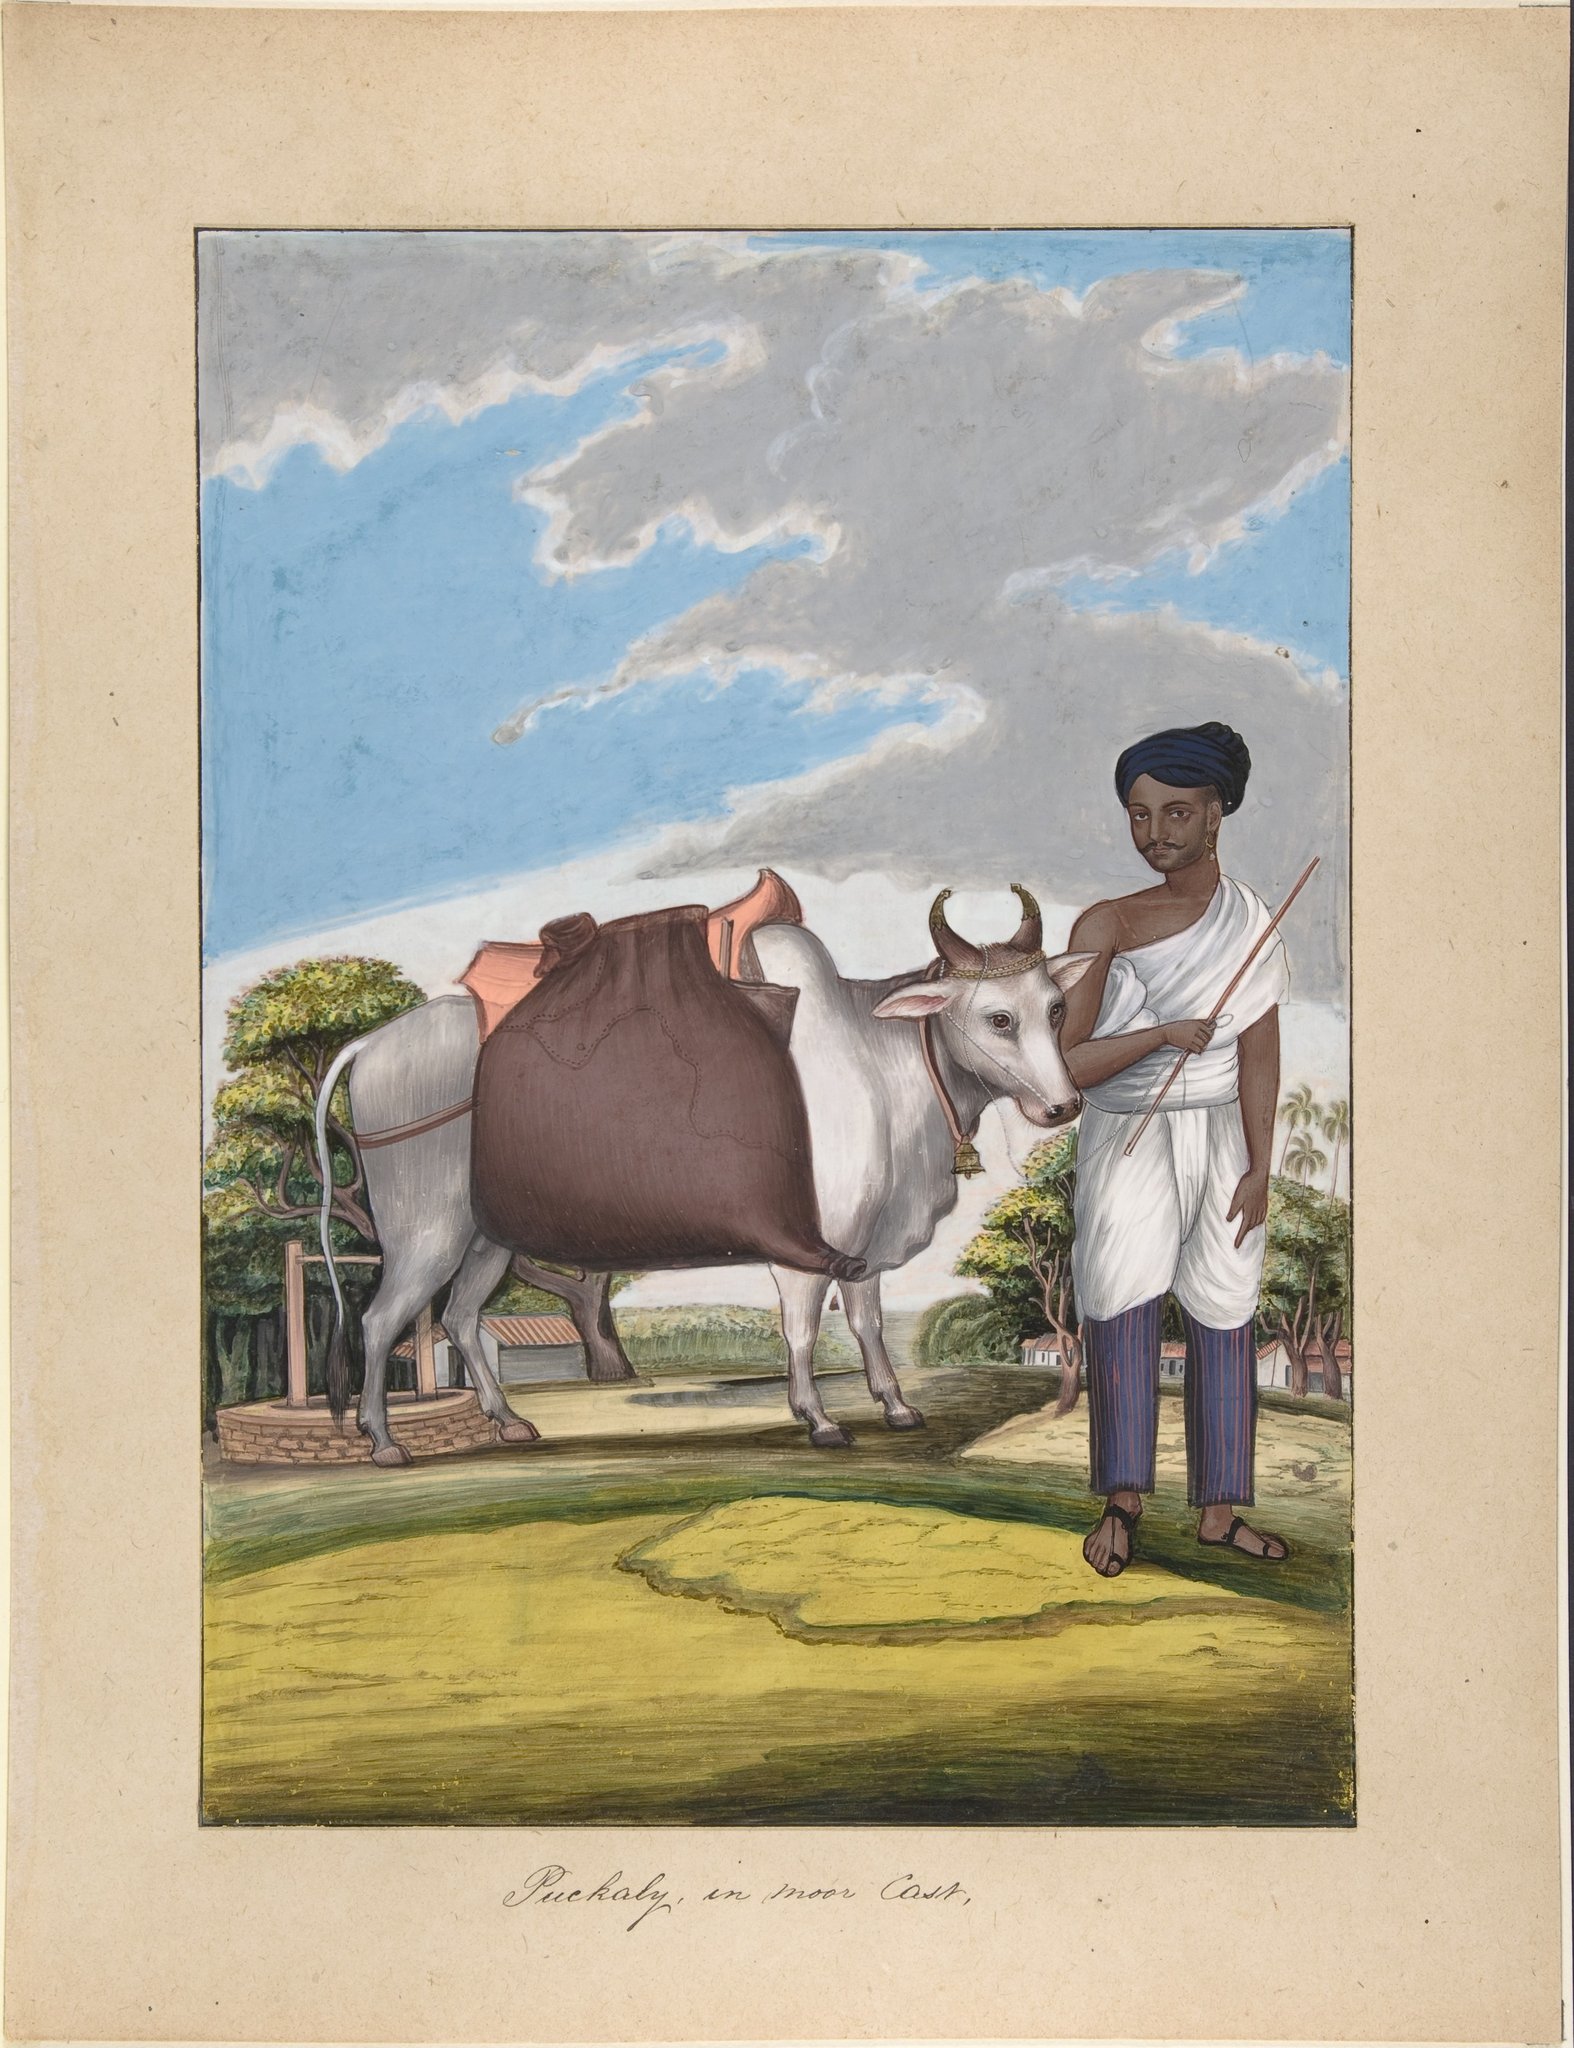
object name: drawing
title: Puckaly in Moor Cast, from Indian Trades and Castes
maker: anonymous, indian, 19th century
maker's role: artist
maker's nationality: indian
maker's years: 1800-1900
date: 1840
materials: gouache, watercolor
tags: men,cows